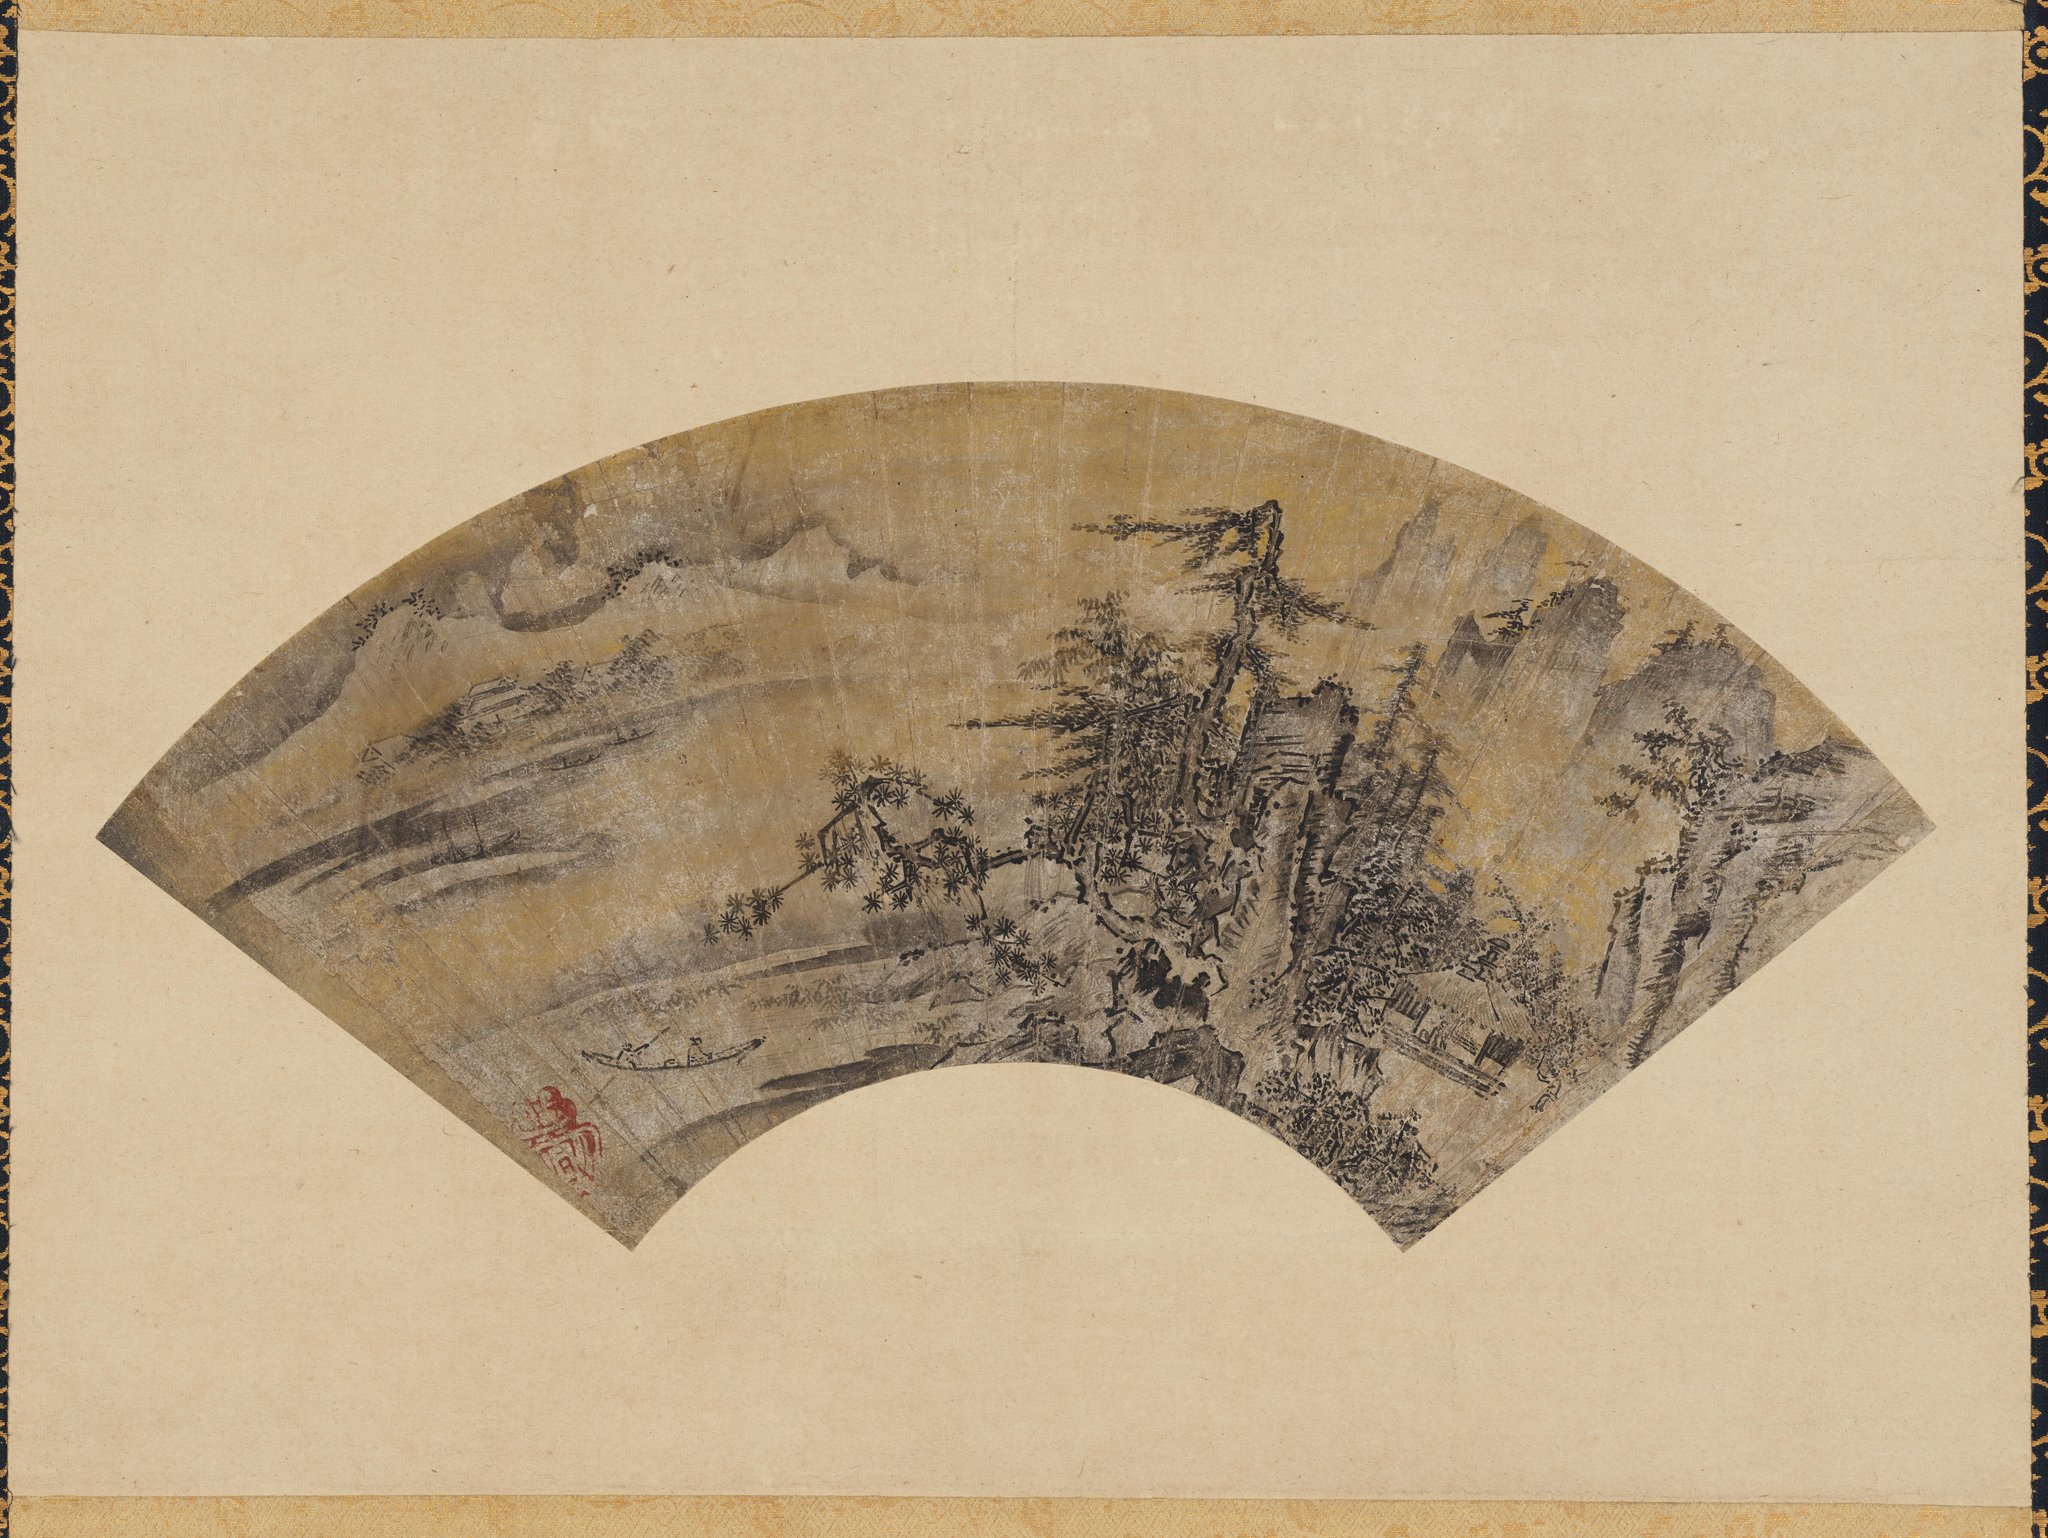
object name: hanging scroll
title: Snowy Landscape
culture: japanese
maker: toki tōbun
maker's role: artist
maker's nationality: japanese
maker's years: 1502-1582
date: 1550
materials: gold, ink, mica, paper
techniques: wash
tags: landscapes